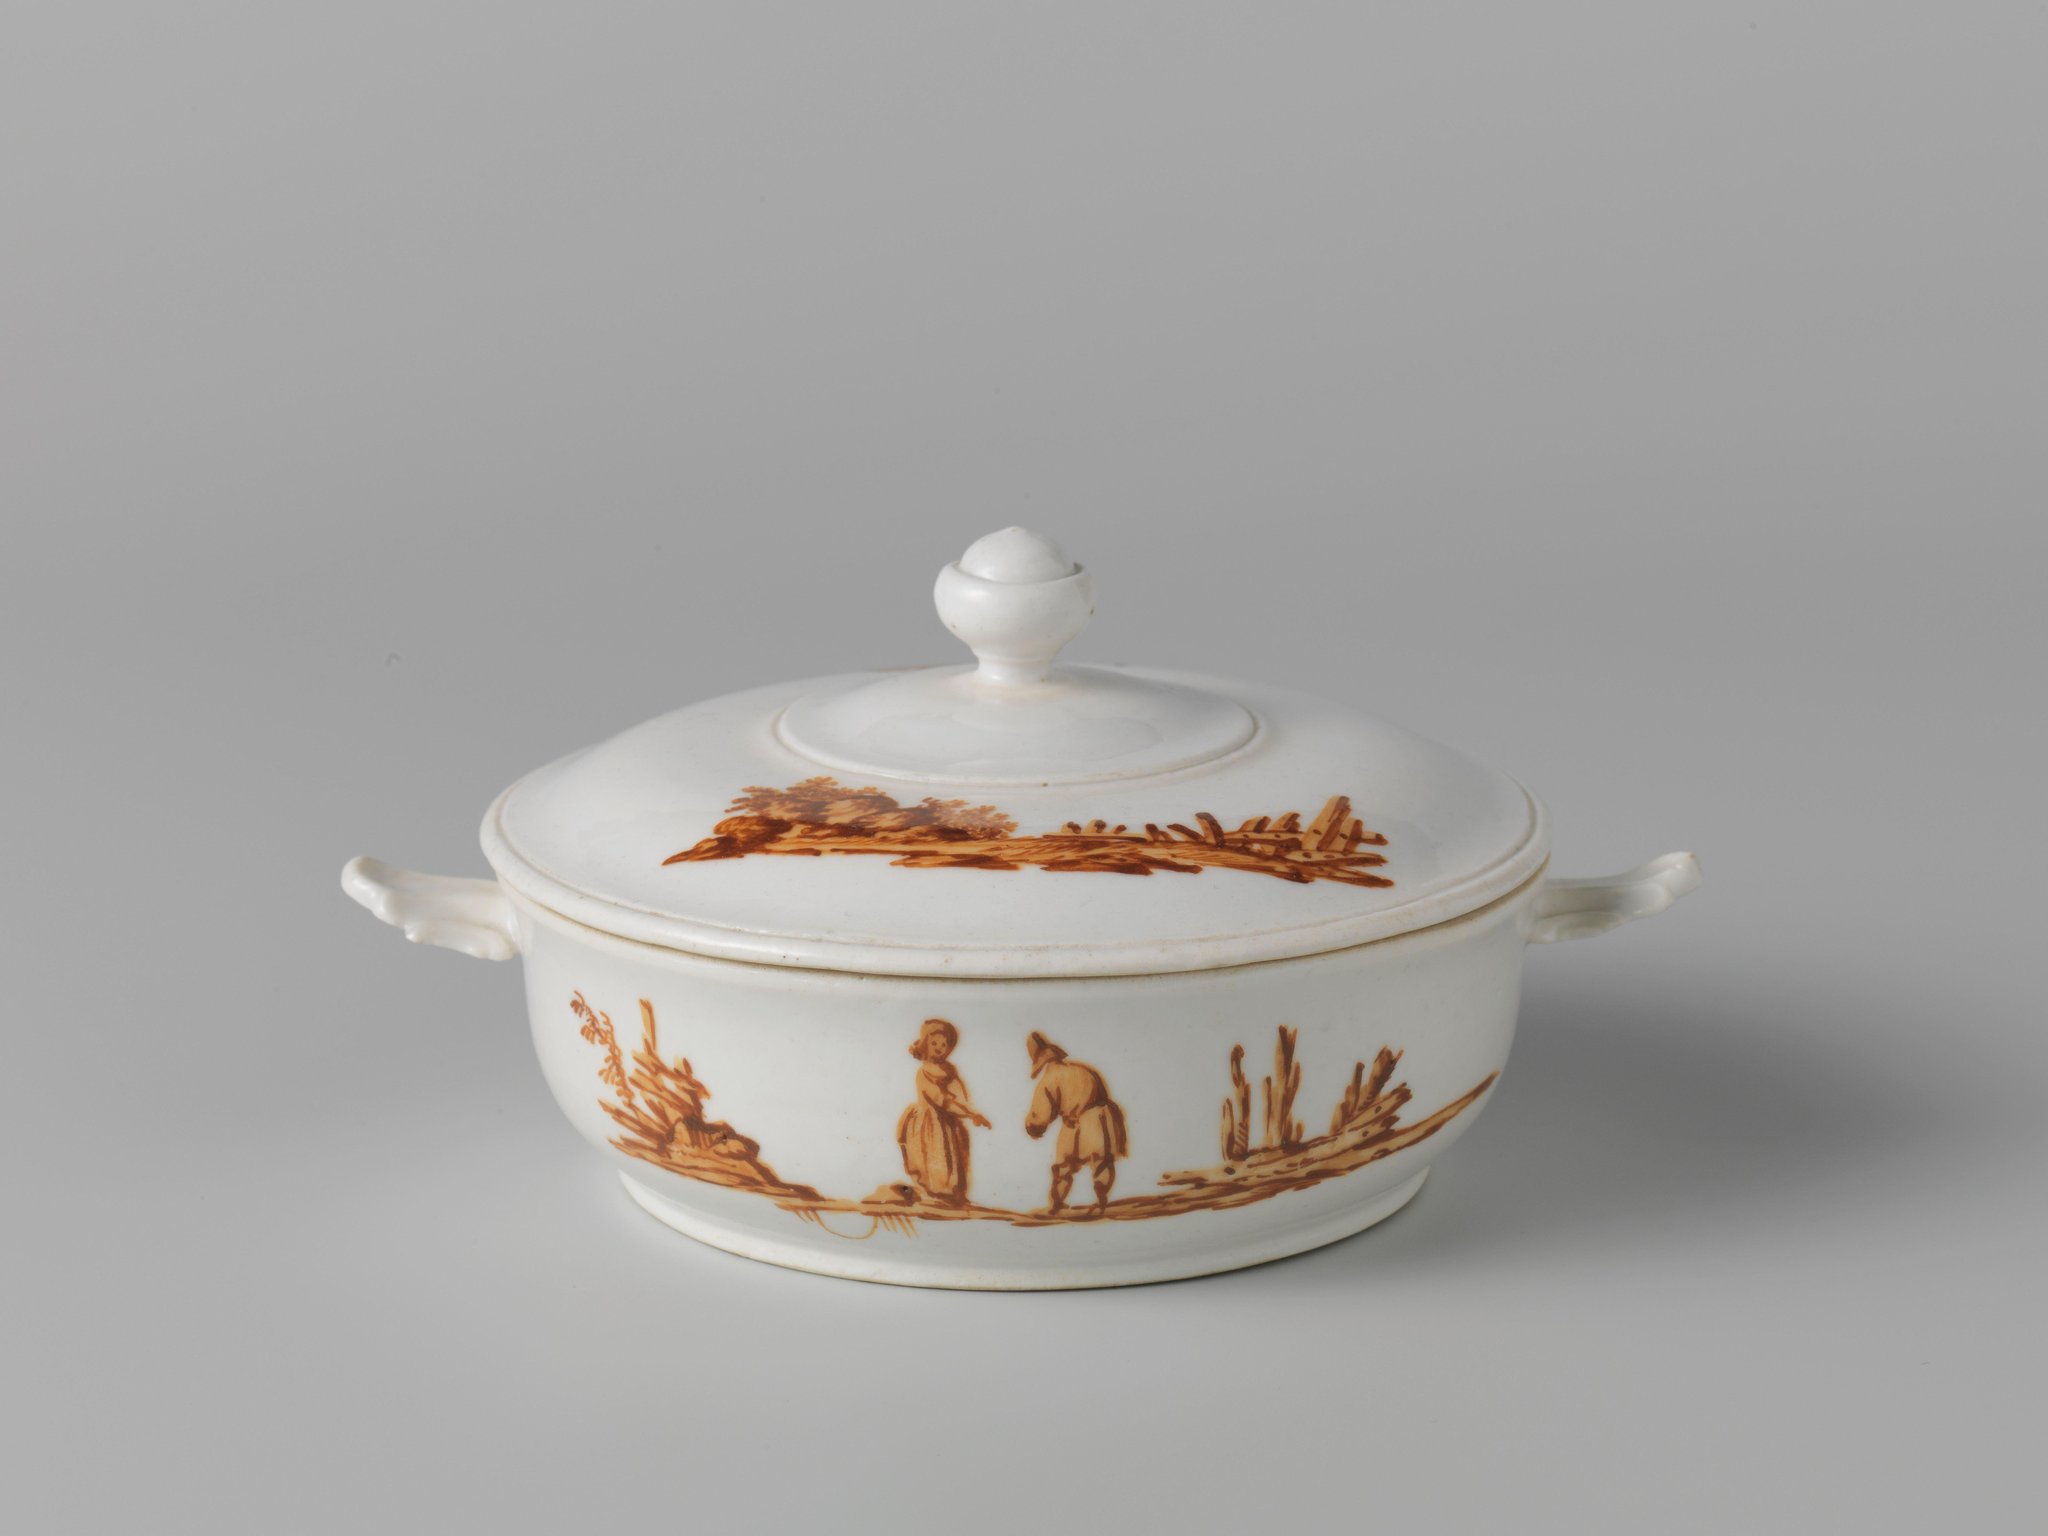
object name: lid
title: Deksel van botervloot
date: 1774-1778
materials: porcelain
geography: loosdrecht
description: Deksel van porselein. Licht gewelfde gladde wand en deksel. Deksel met geprofileerde rand en iets verhoogd en geprofileerd middenstuk met knop. Aan beide zijden van de vloot en twee maal op de deksels een landschapsgrondje in sepia zonder, met één of met twee figuren.